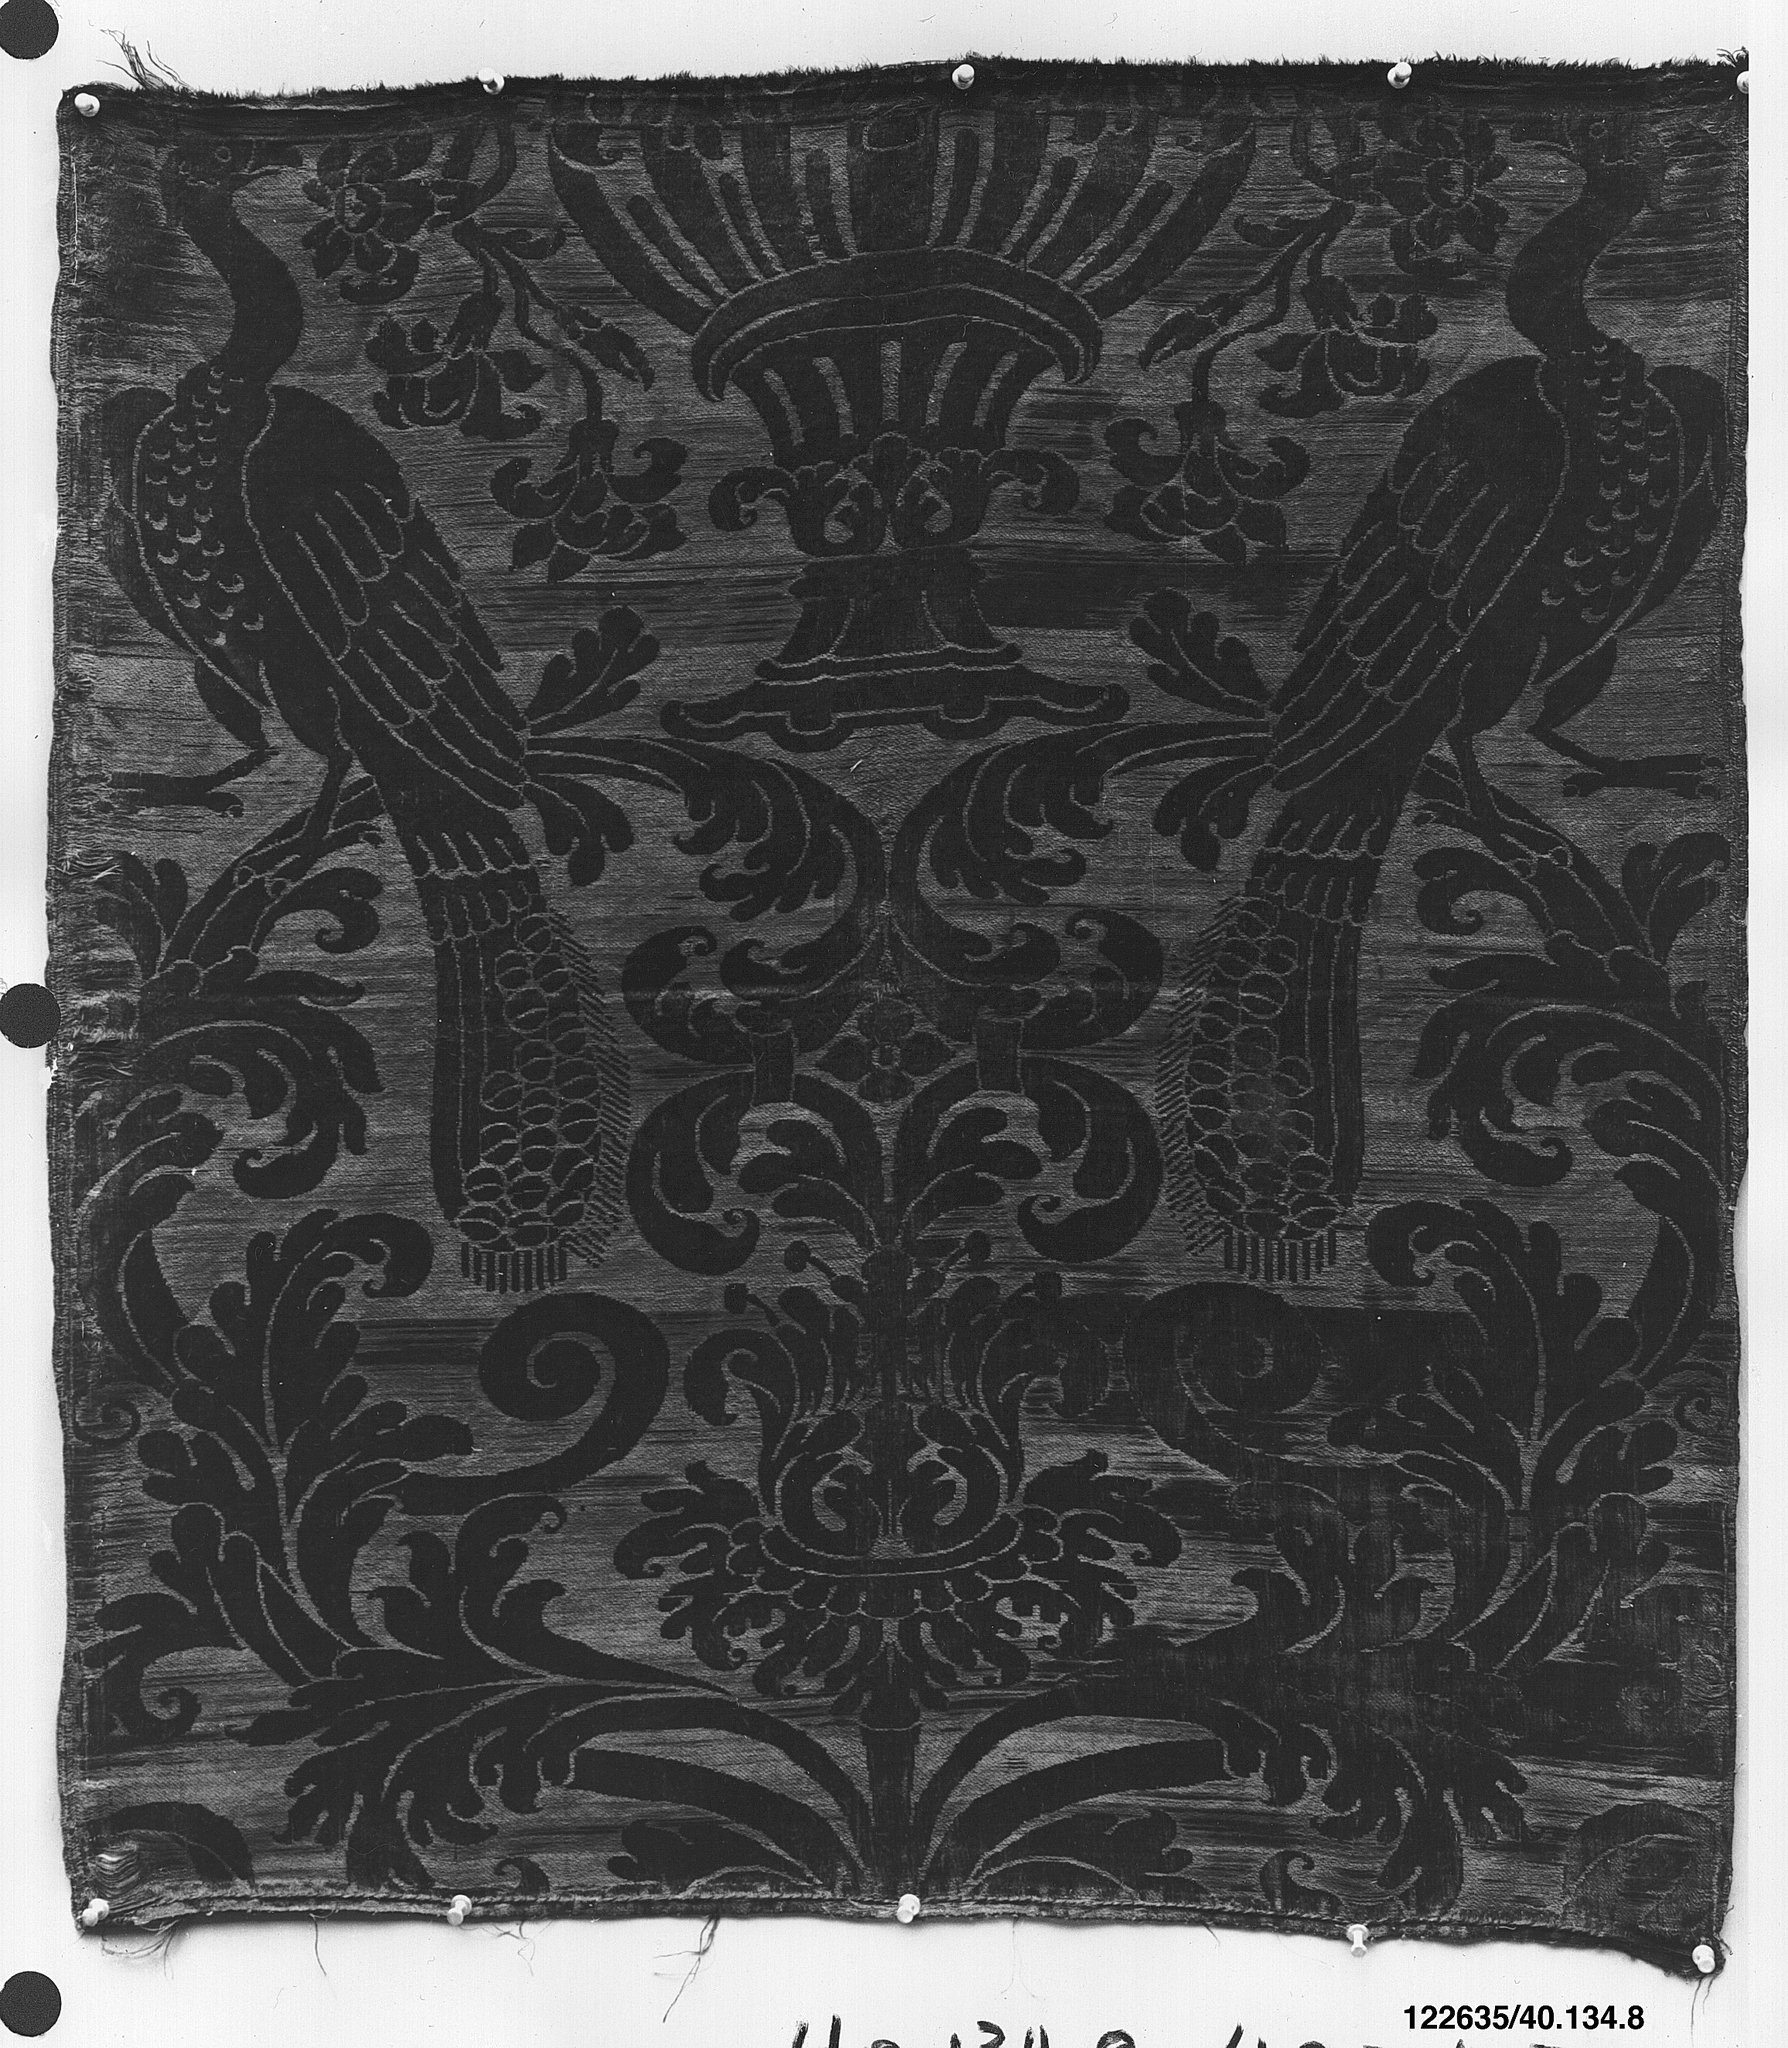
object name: piece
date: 1601-1700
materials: hemp, silk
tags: peacocks,leaves